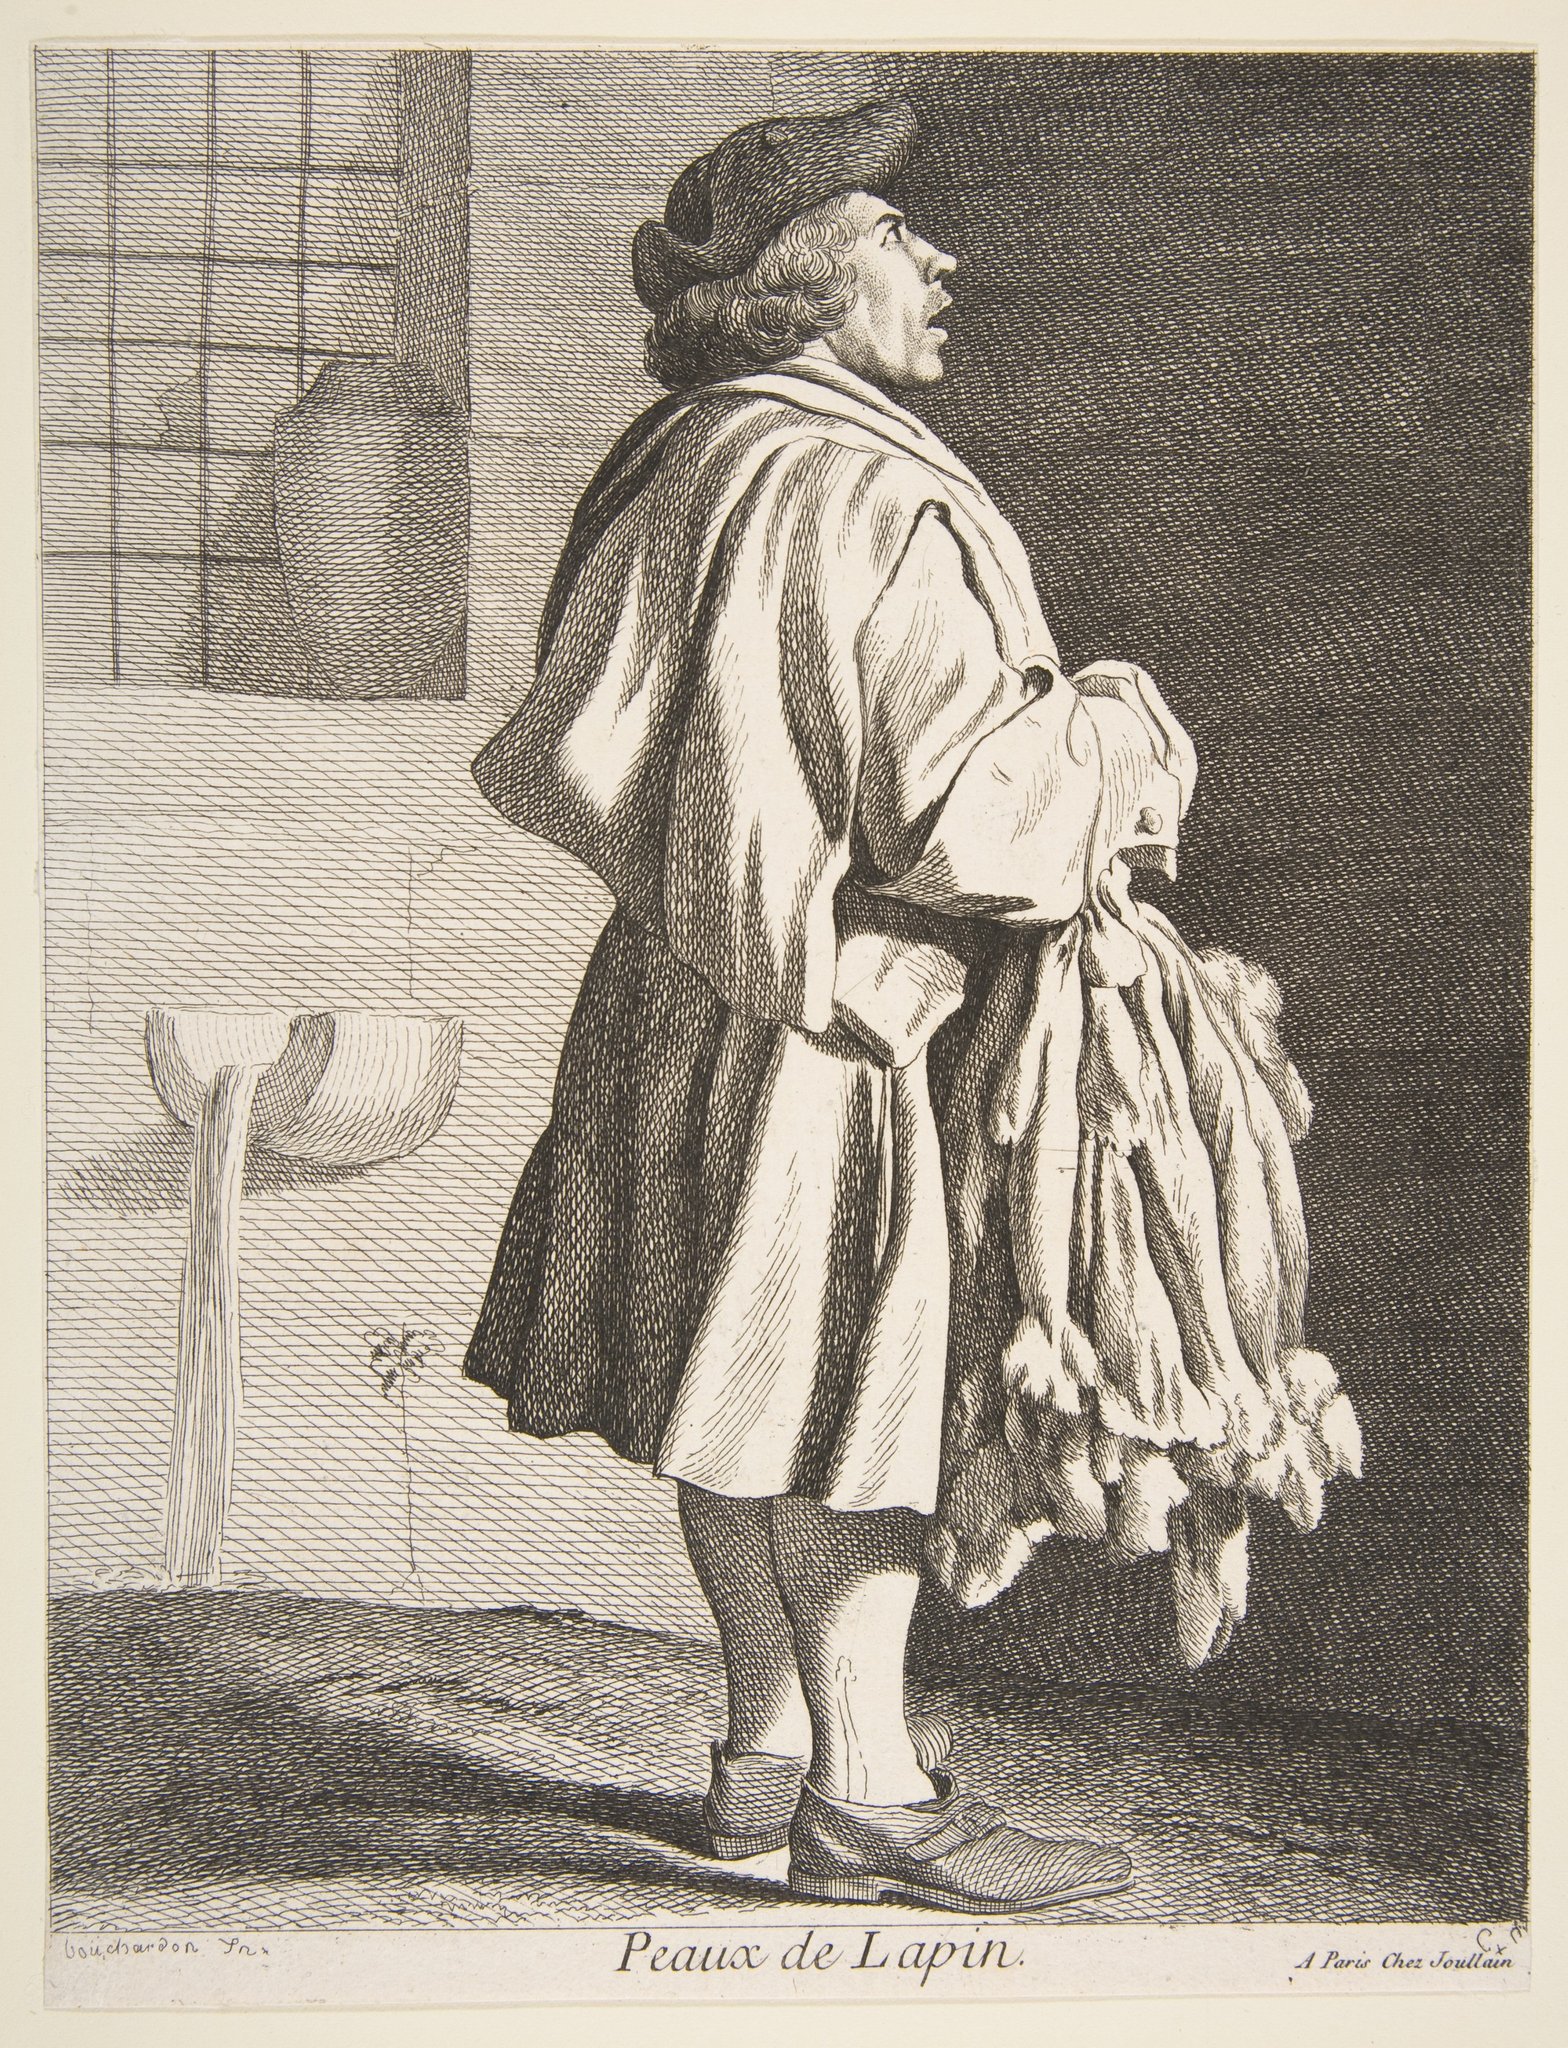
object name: print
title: Rabbit Pelt Peddler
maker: anne claude philippe de tubières, comte de caylus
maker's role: artist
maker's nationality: french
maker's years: 1692-1765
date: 1737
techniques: engraving, etching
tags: men,rabbits